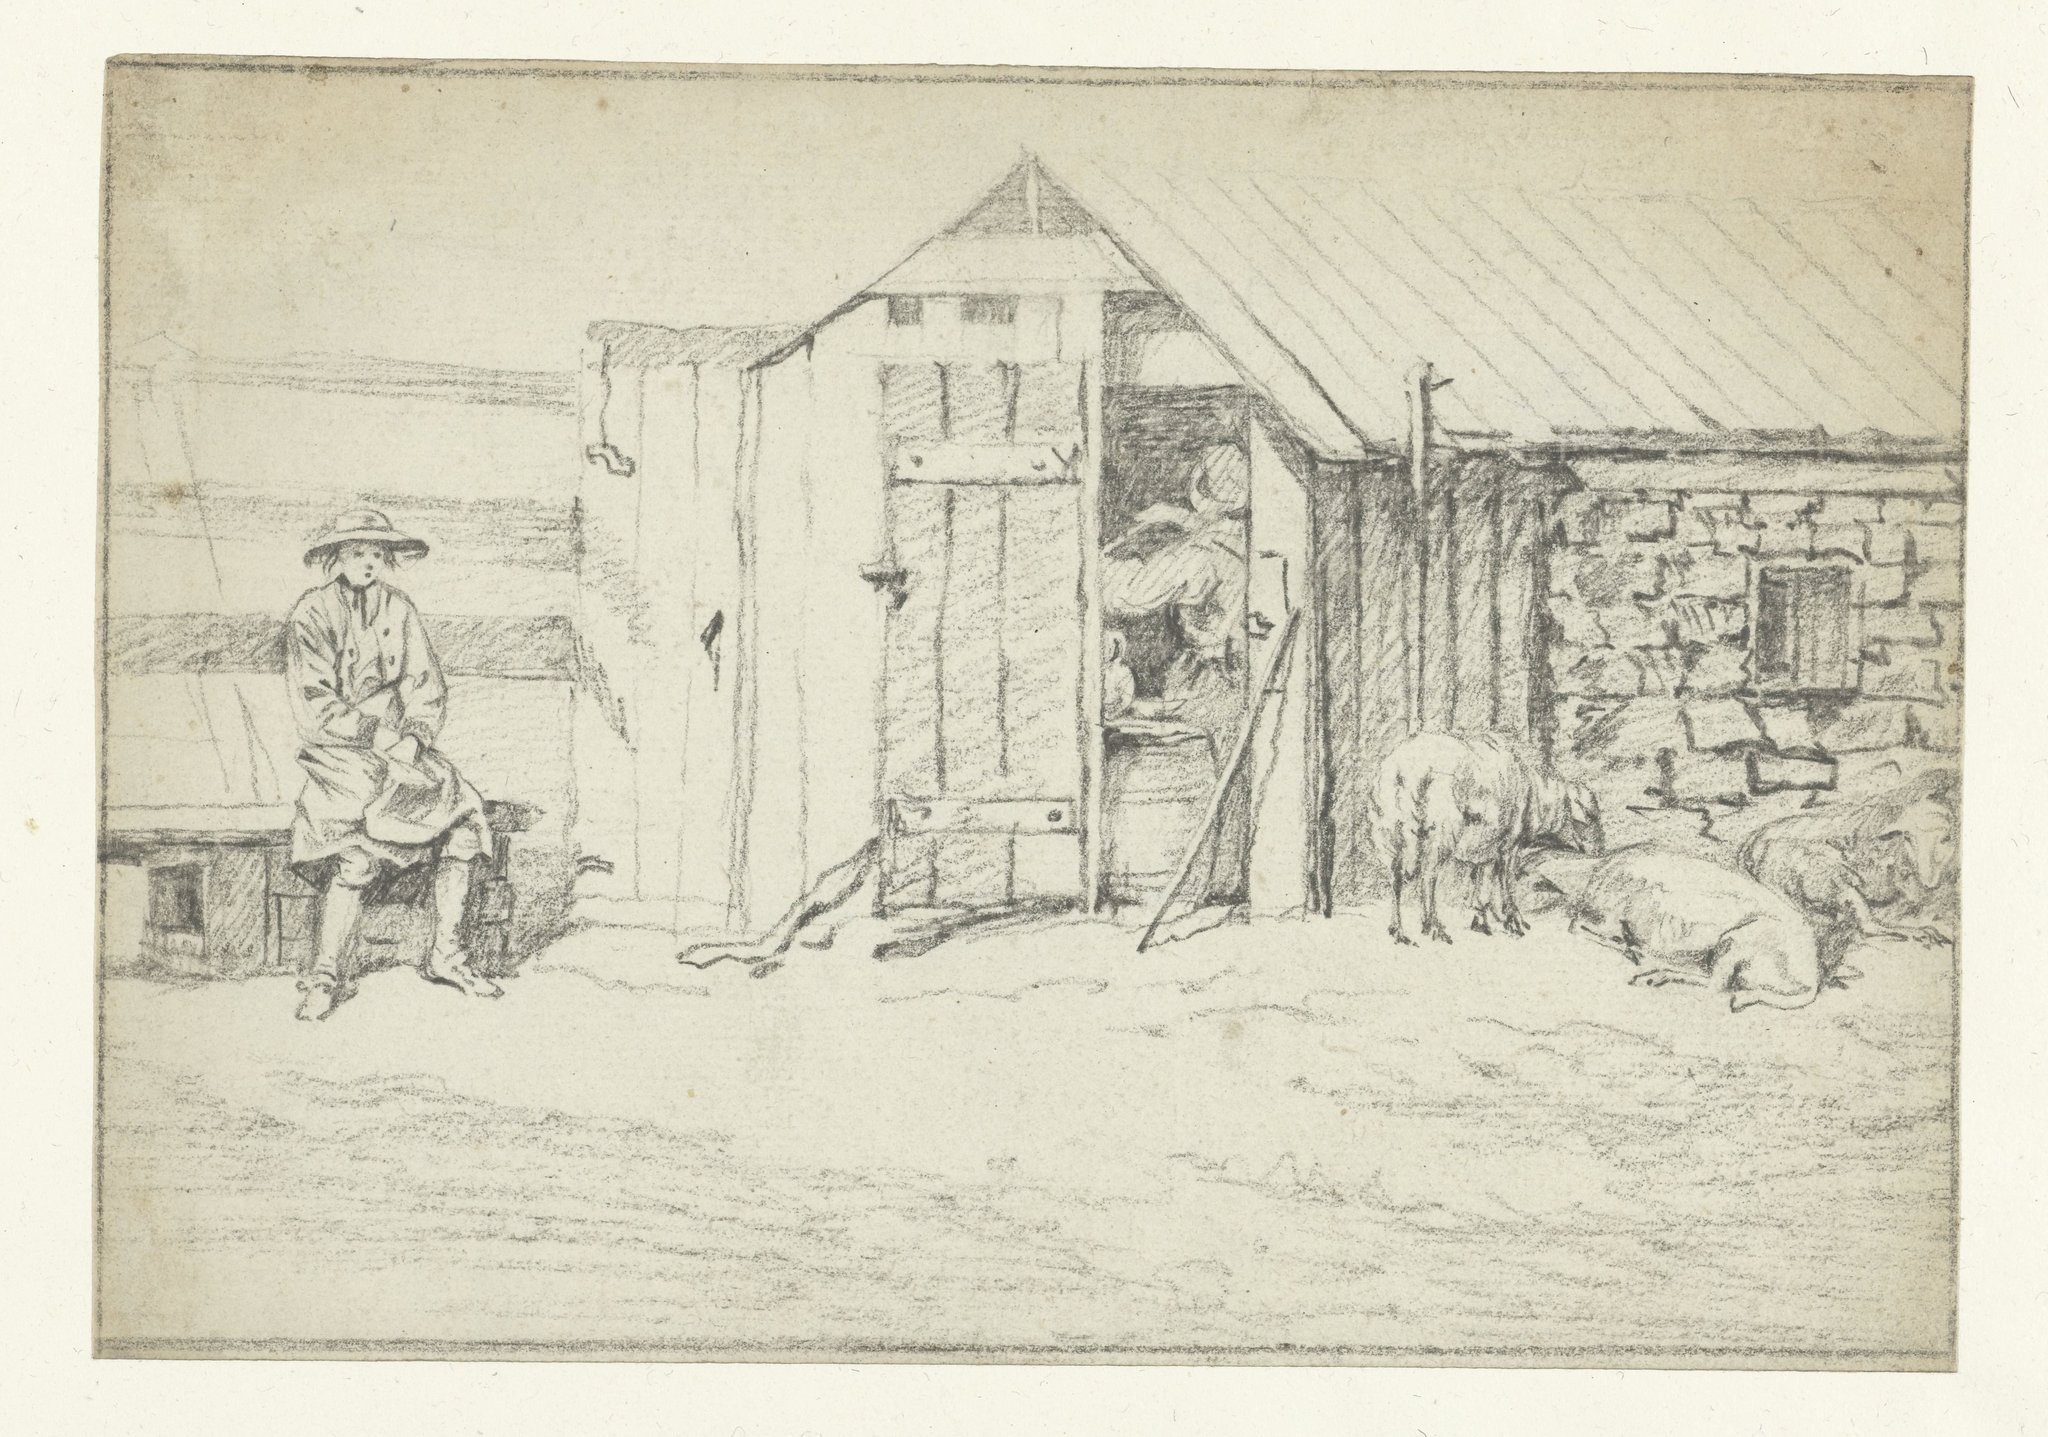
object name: drawing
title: Jongeman op een bank bij een boerenhuis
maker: auguste claude simon legrand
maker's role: draughtsman, print maker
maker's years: 1765-1825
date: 1775-1815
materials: chalk, paper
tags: herding, herdsman, herdswoman, shepherd, shepherdess, cowherd, etc., sheep, farm (building)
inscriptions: annotation, verso, upper left, purple ink: ‘Rt’, annotation, verso, upper left, pencil: ‘W. Kaller [?] 1850’, annotation, verso, to the right, pencil: ‘146’, annotation, verso, centre, pencil: ‘A. v. d. Werft’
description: Bij een boerenhuis zit een jongeman op een bank, rechts een drietal schapen.